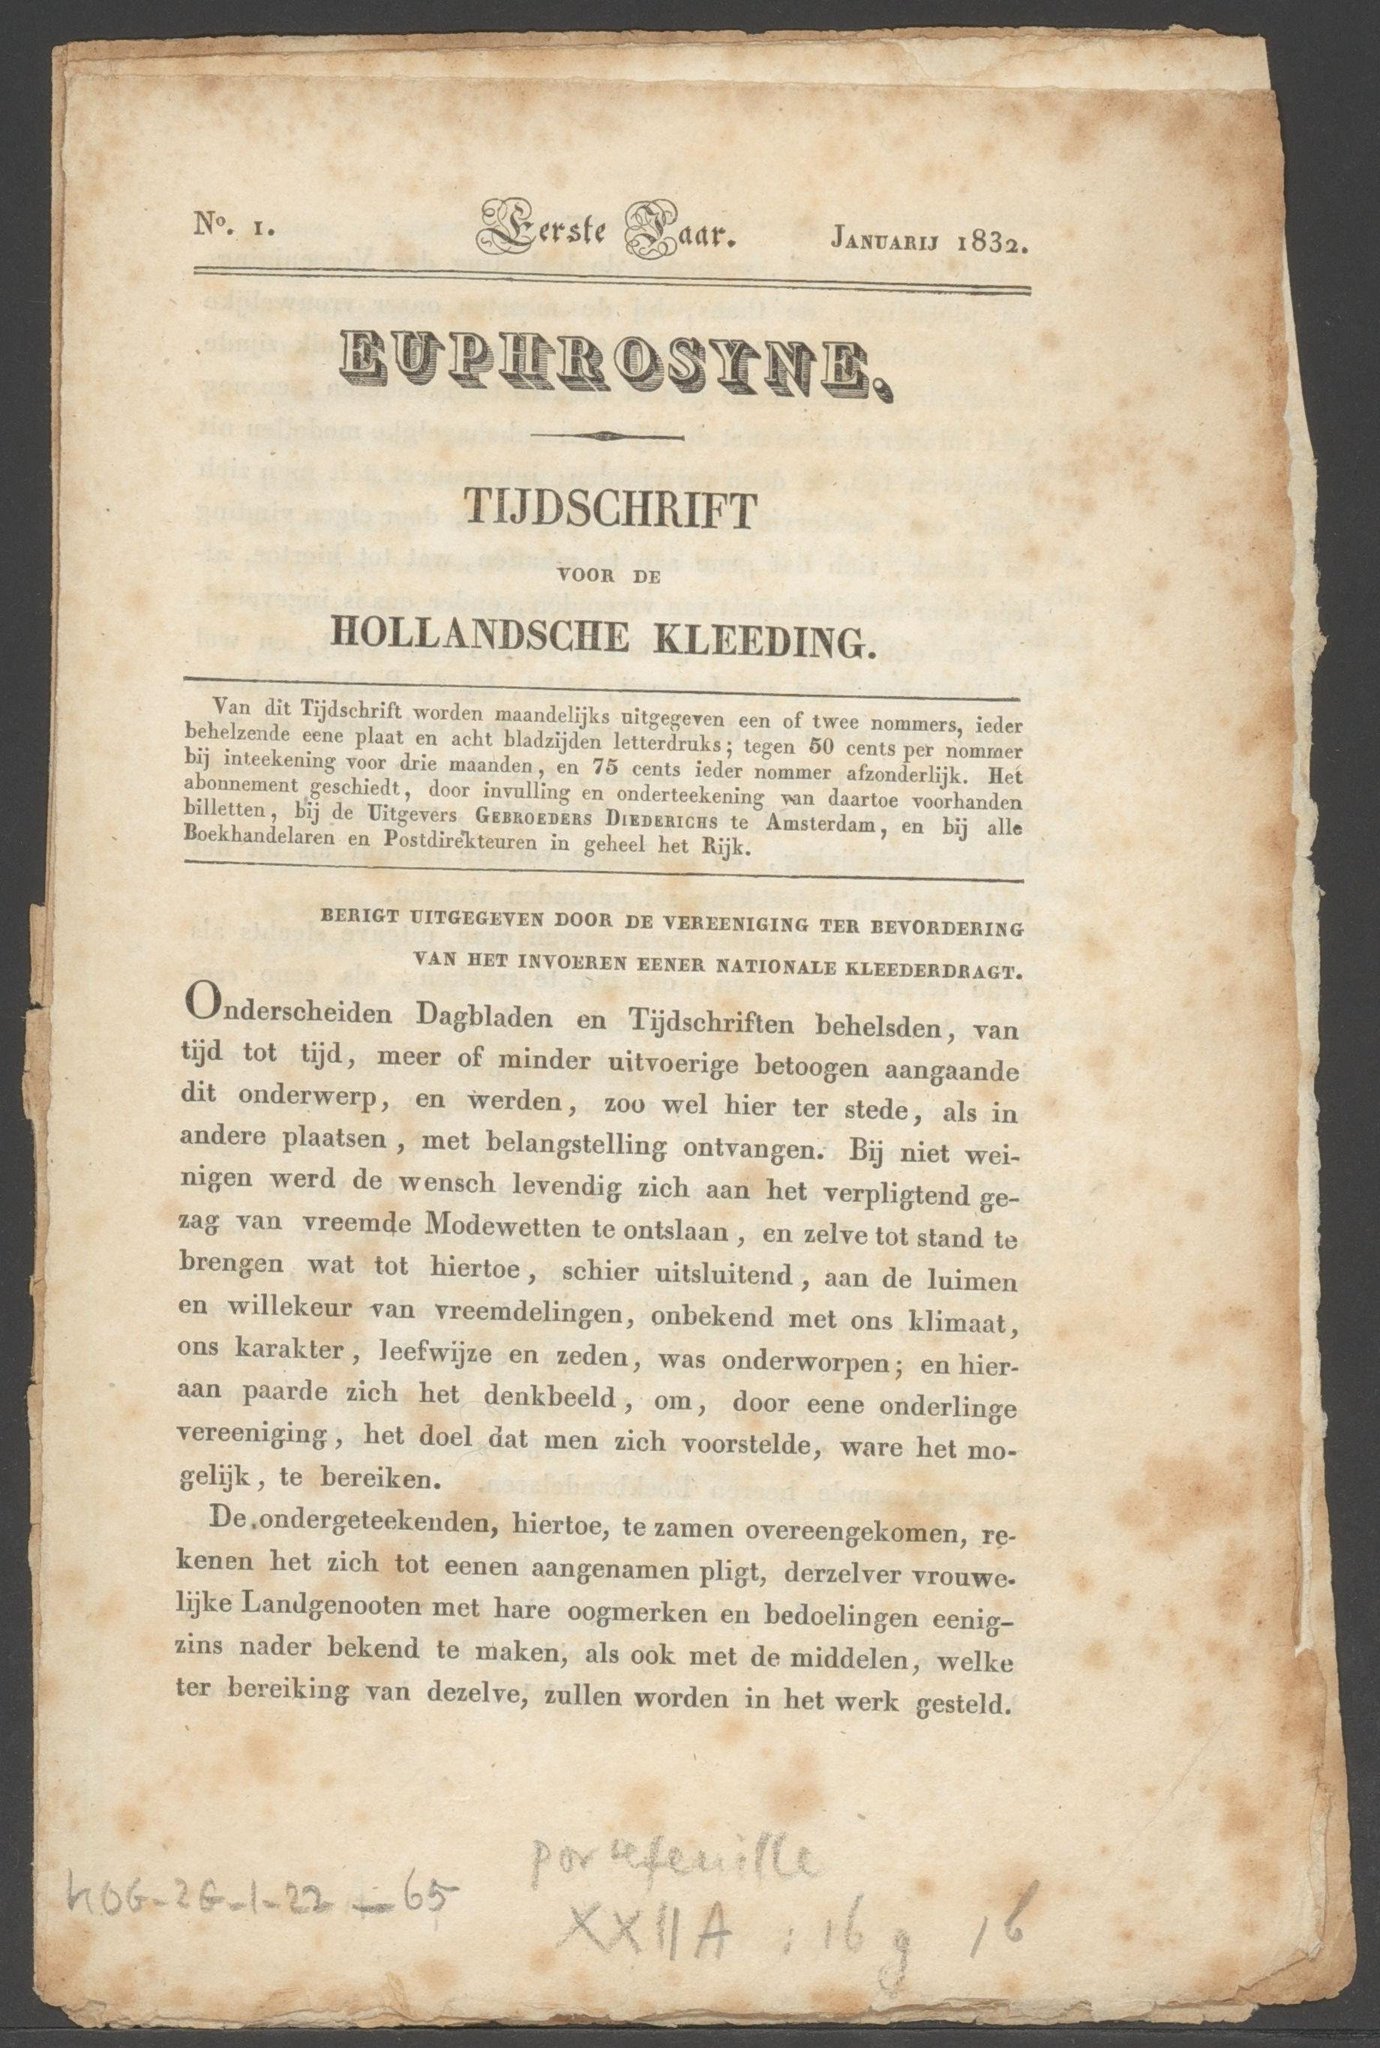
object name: prospectus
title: Euphrosyne. Tijdschrift voor de Hollandsche Kleeding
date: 1801-1832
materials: paper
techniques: letterpress printing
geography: netherlands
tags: folk costume, regional costume, clothes, costume, netherlands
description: Eerste aflevering van het tijdschrift 'Euphrosyne. Tijdschrift voor de Hollandsche Kleeding', No. 1, januari 1832. Een los en een dubbelgevouwen blad, genummerd blz. 1-6 (incompleet). Onderwerpsrubrieken binnen de Atlas Zeden en Gewoonten: De Kleeding, Volkskleederdracht.